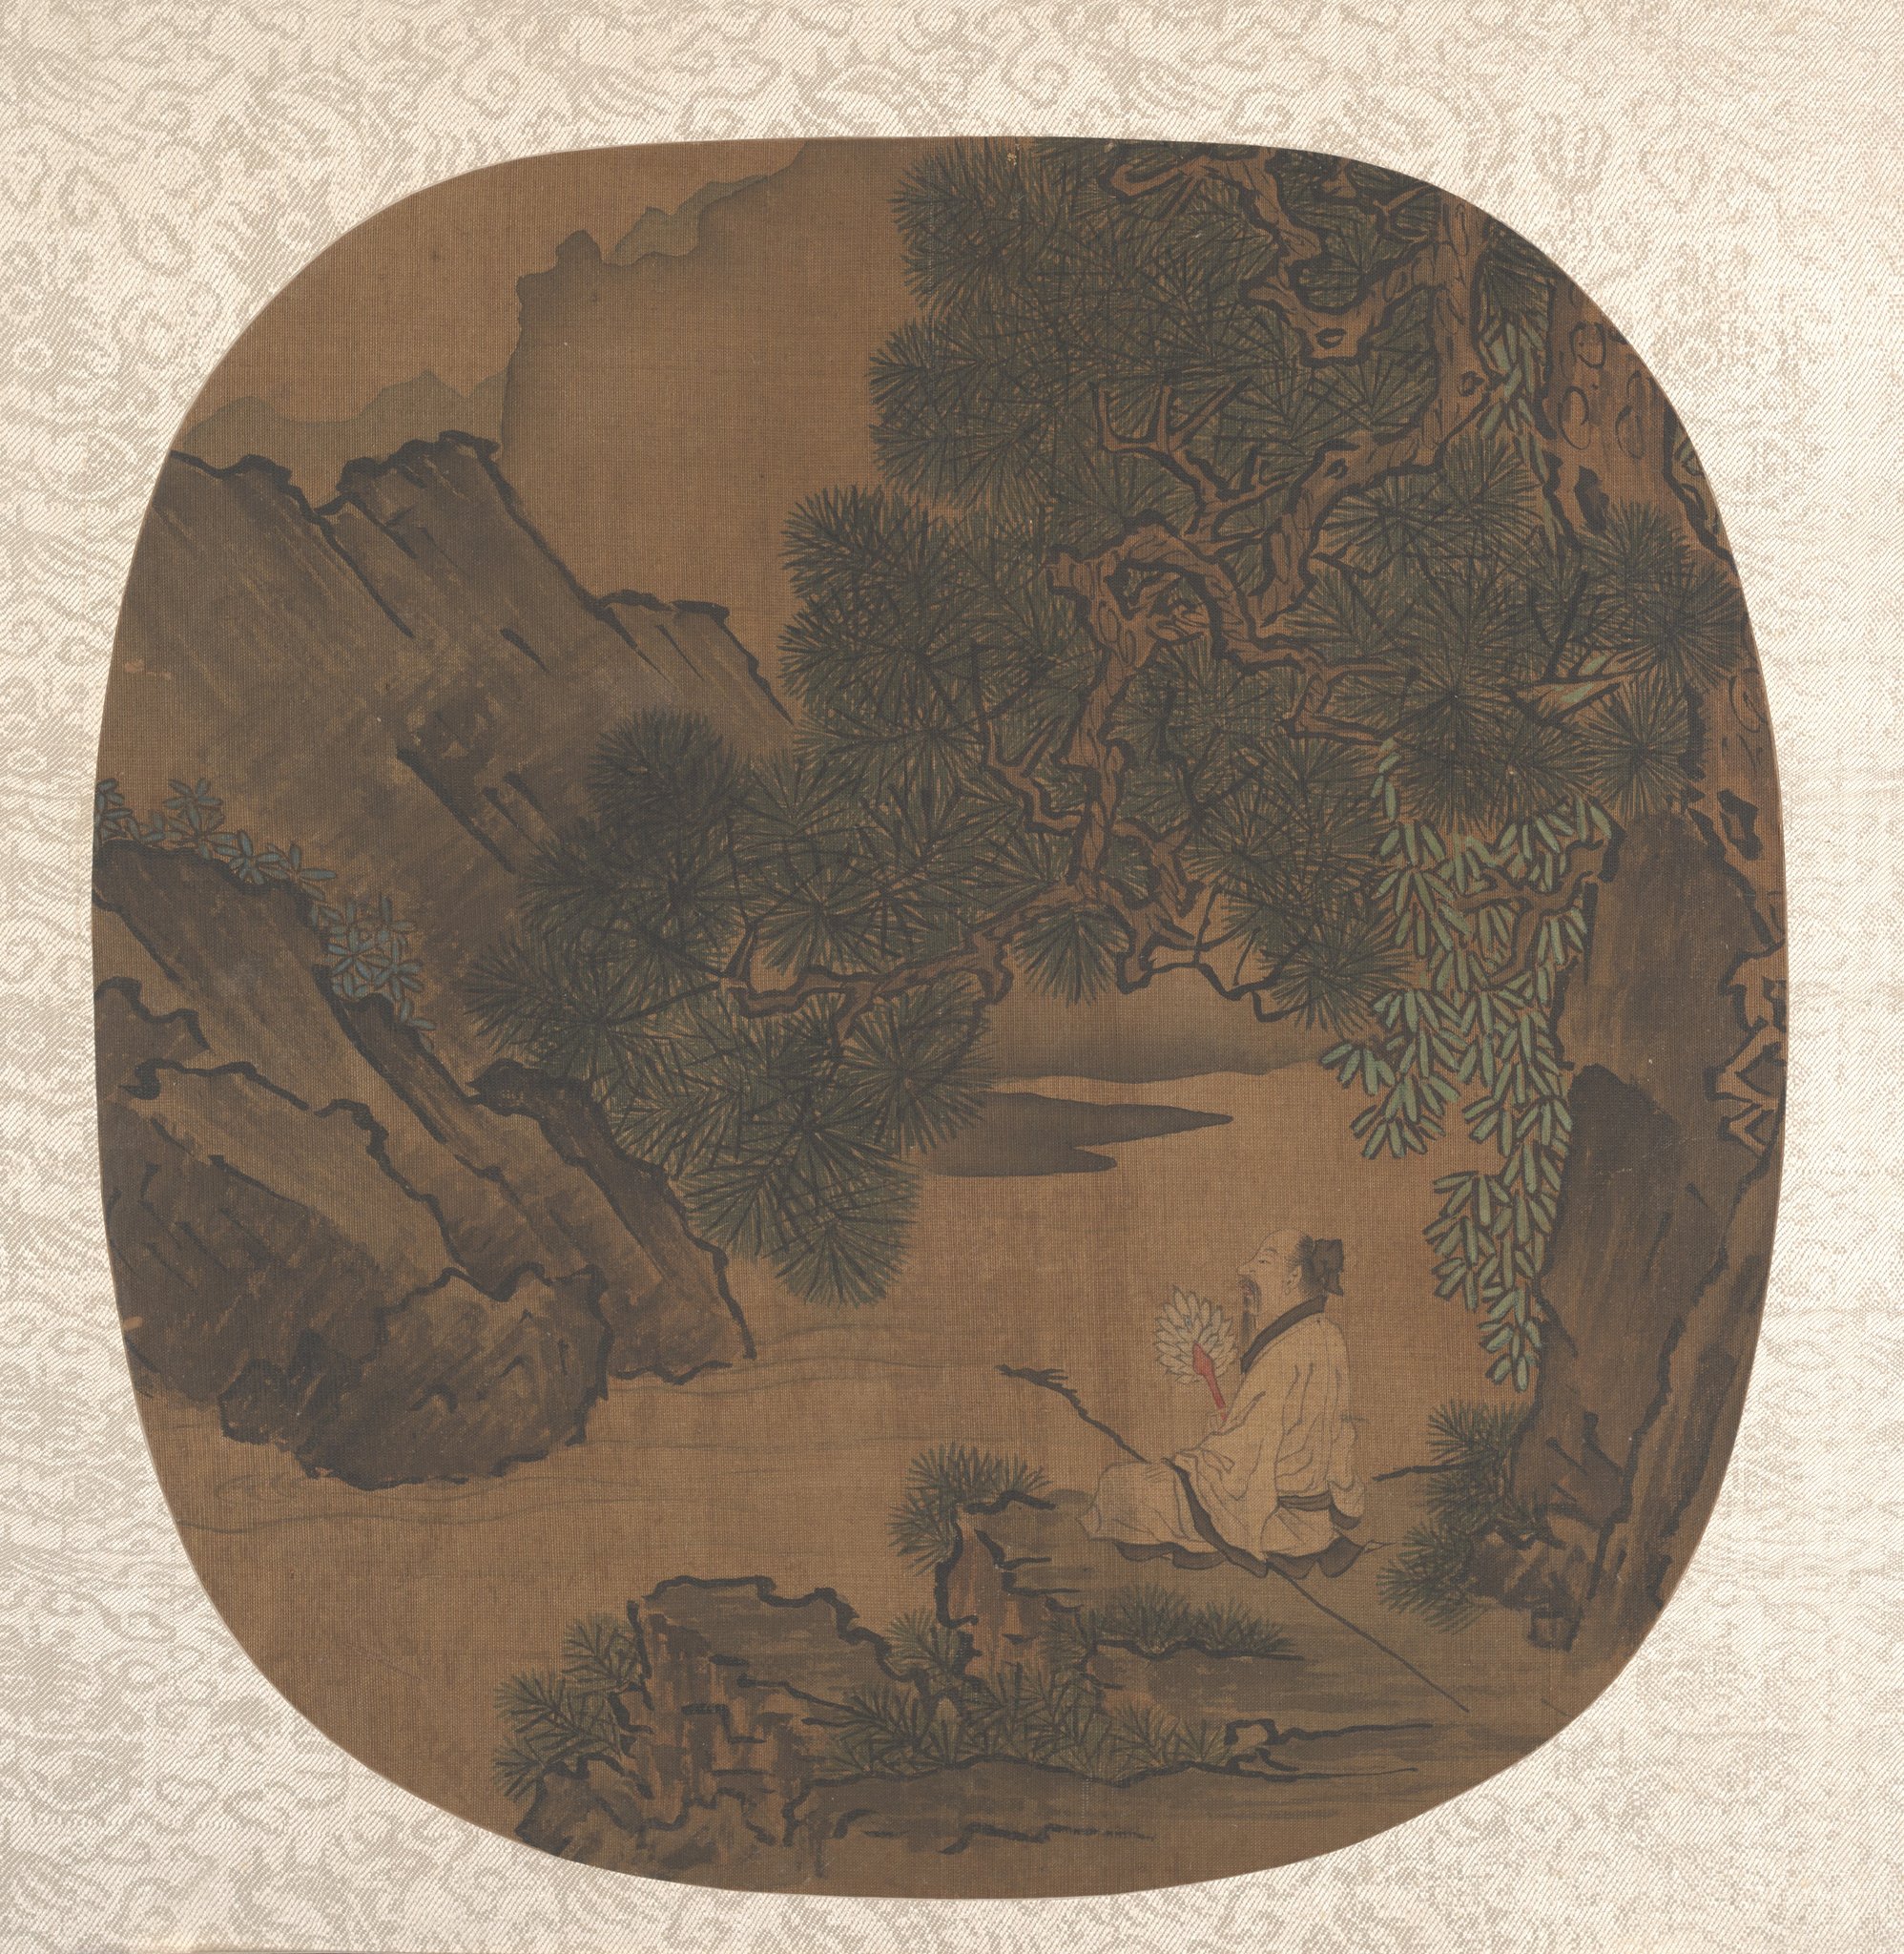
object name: fan mounted a an album leaf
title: Near the Spring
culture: chinese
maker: unidentified artist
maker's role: artist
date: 1644-1911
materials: ink, silk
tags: men,mountains,landscapes